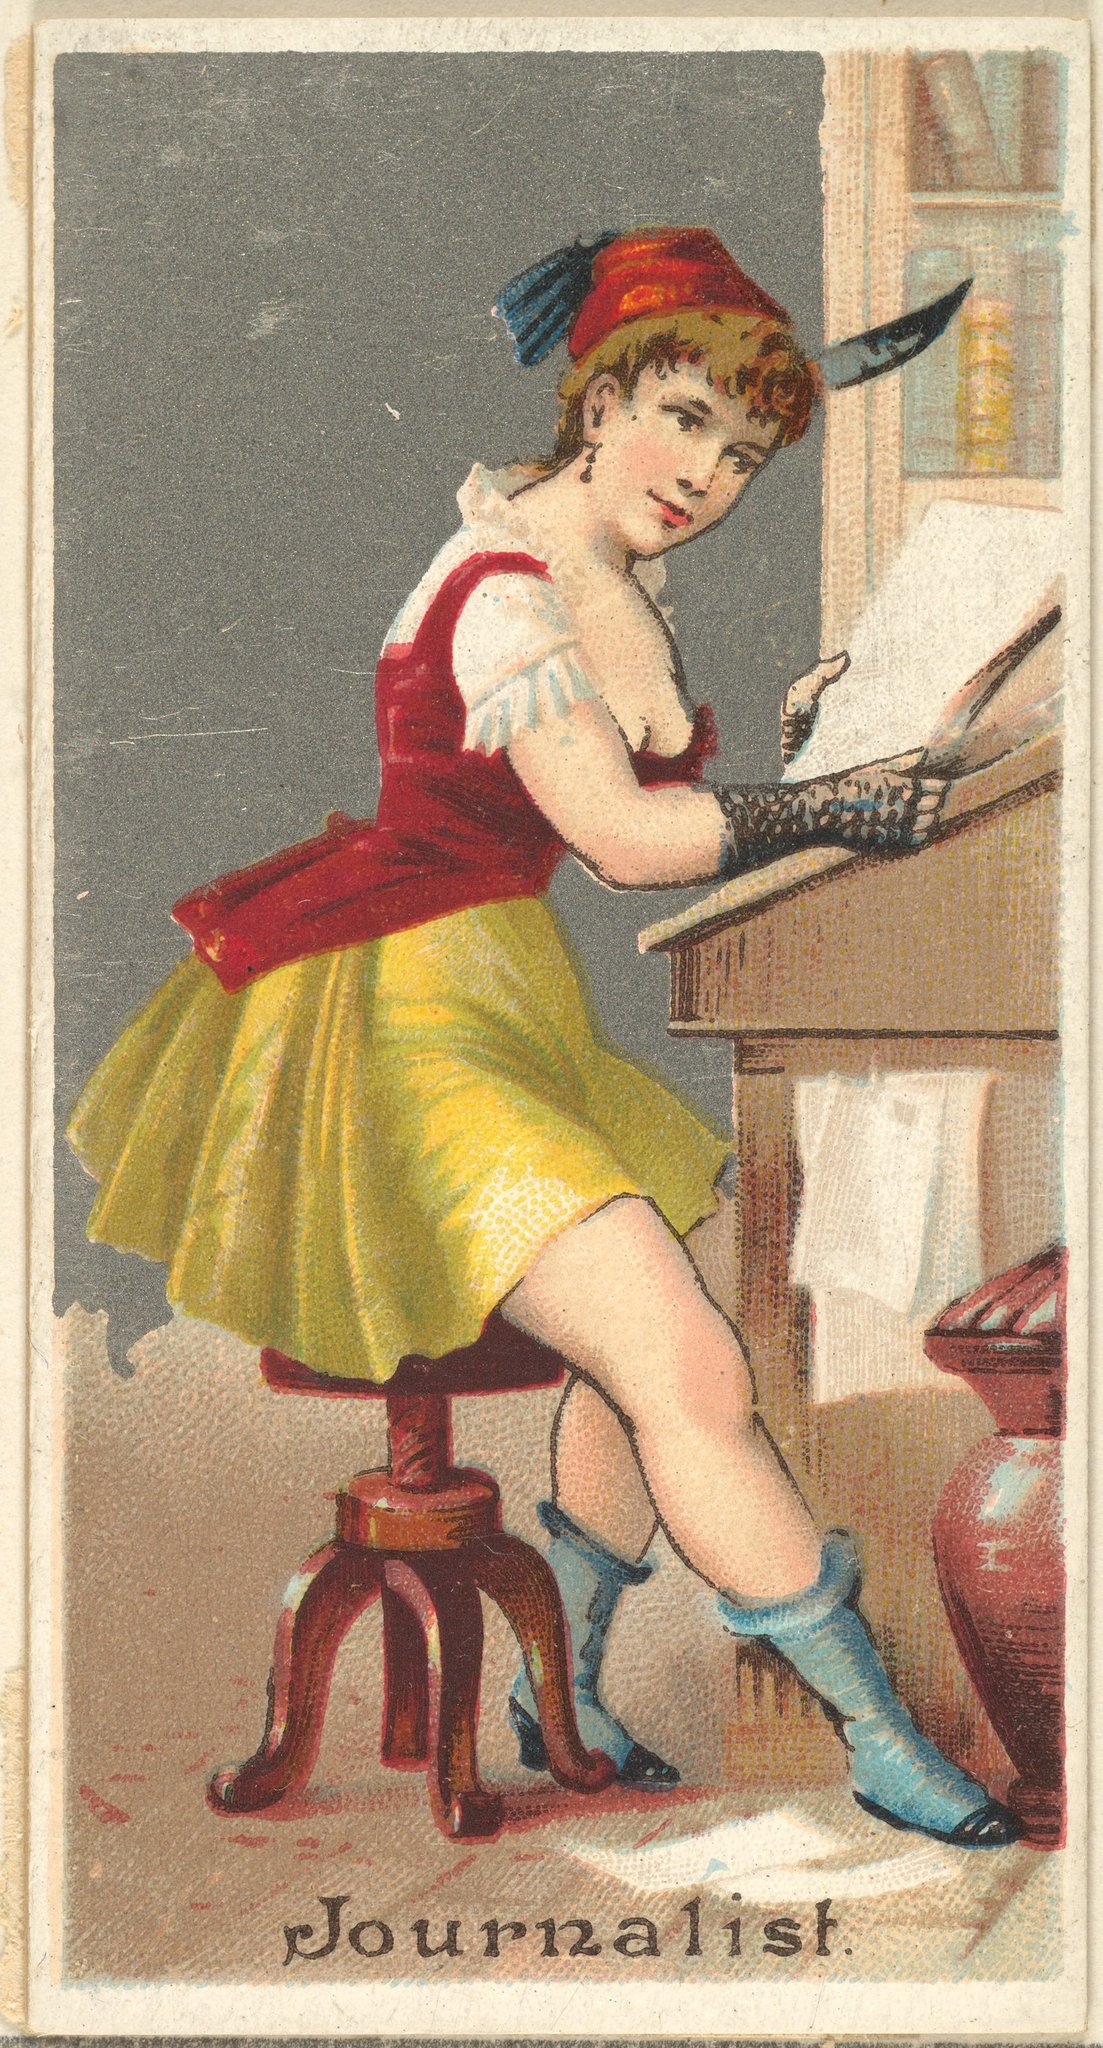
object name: print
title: Journalist, from the Occupations for Women series (N166) for Old Judge and Dogs Head Cigarettes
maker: goodwin & company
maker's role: publisher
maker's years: 1850-1950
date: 1887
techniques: color lithograph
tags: women